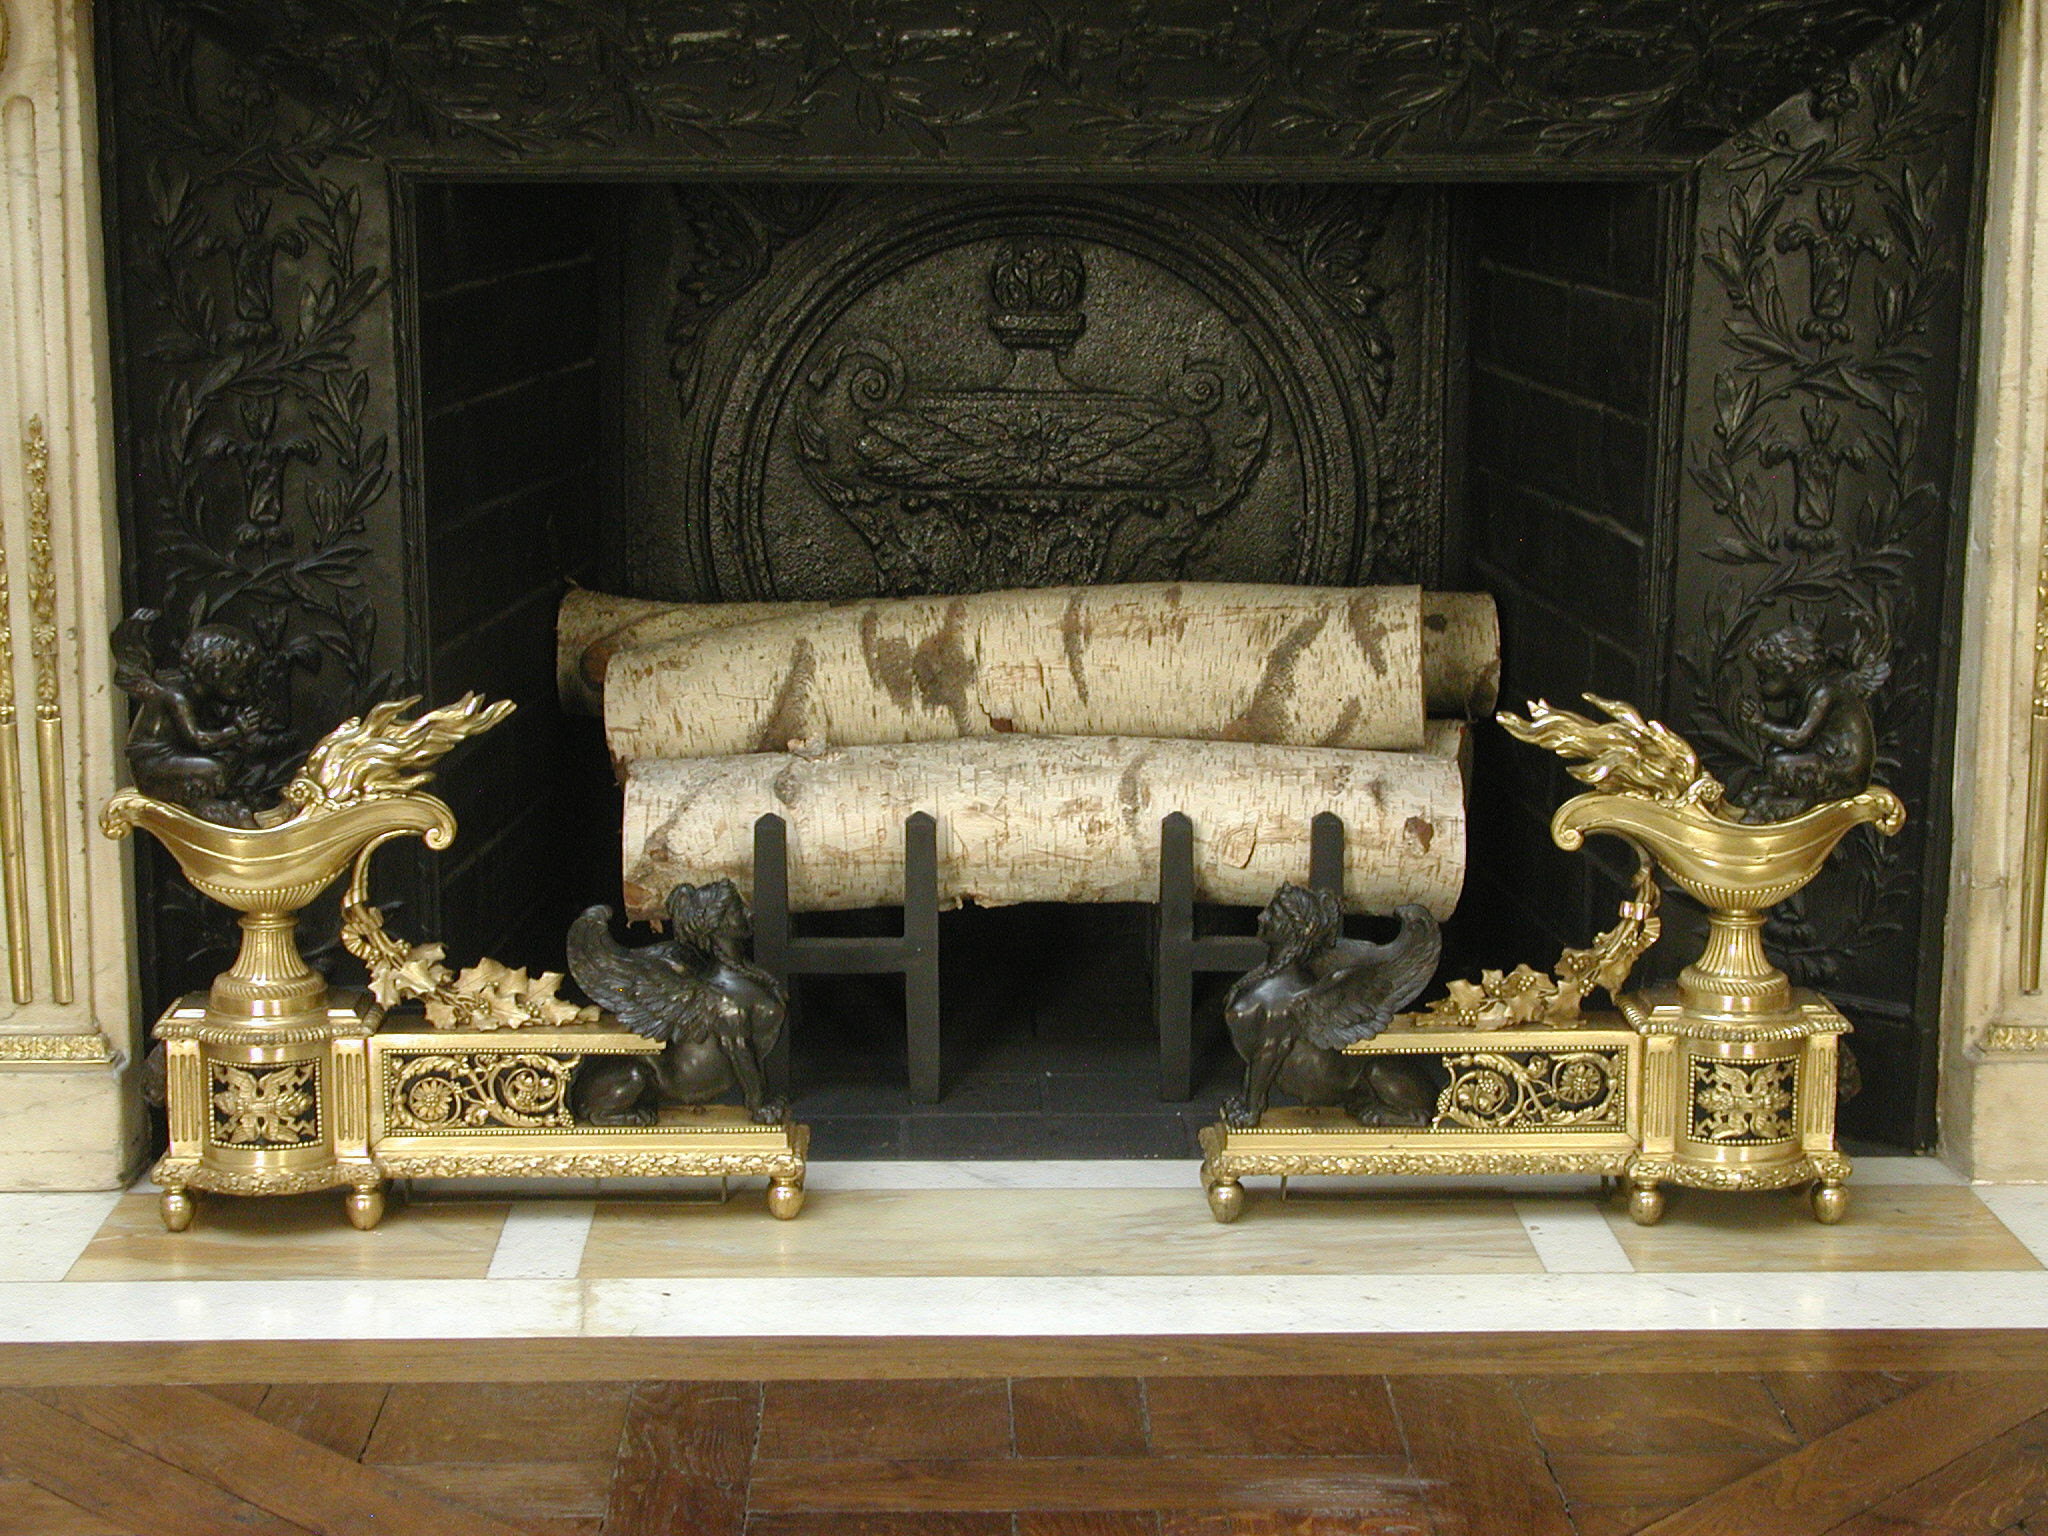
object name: andiron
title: Pair of andirons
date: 1785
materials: bronze, gilt